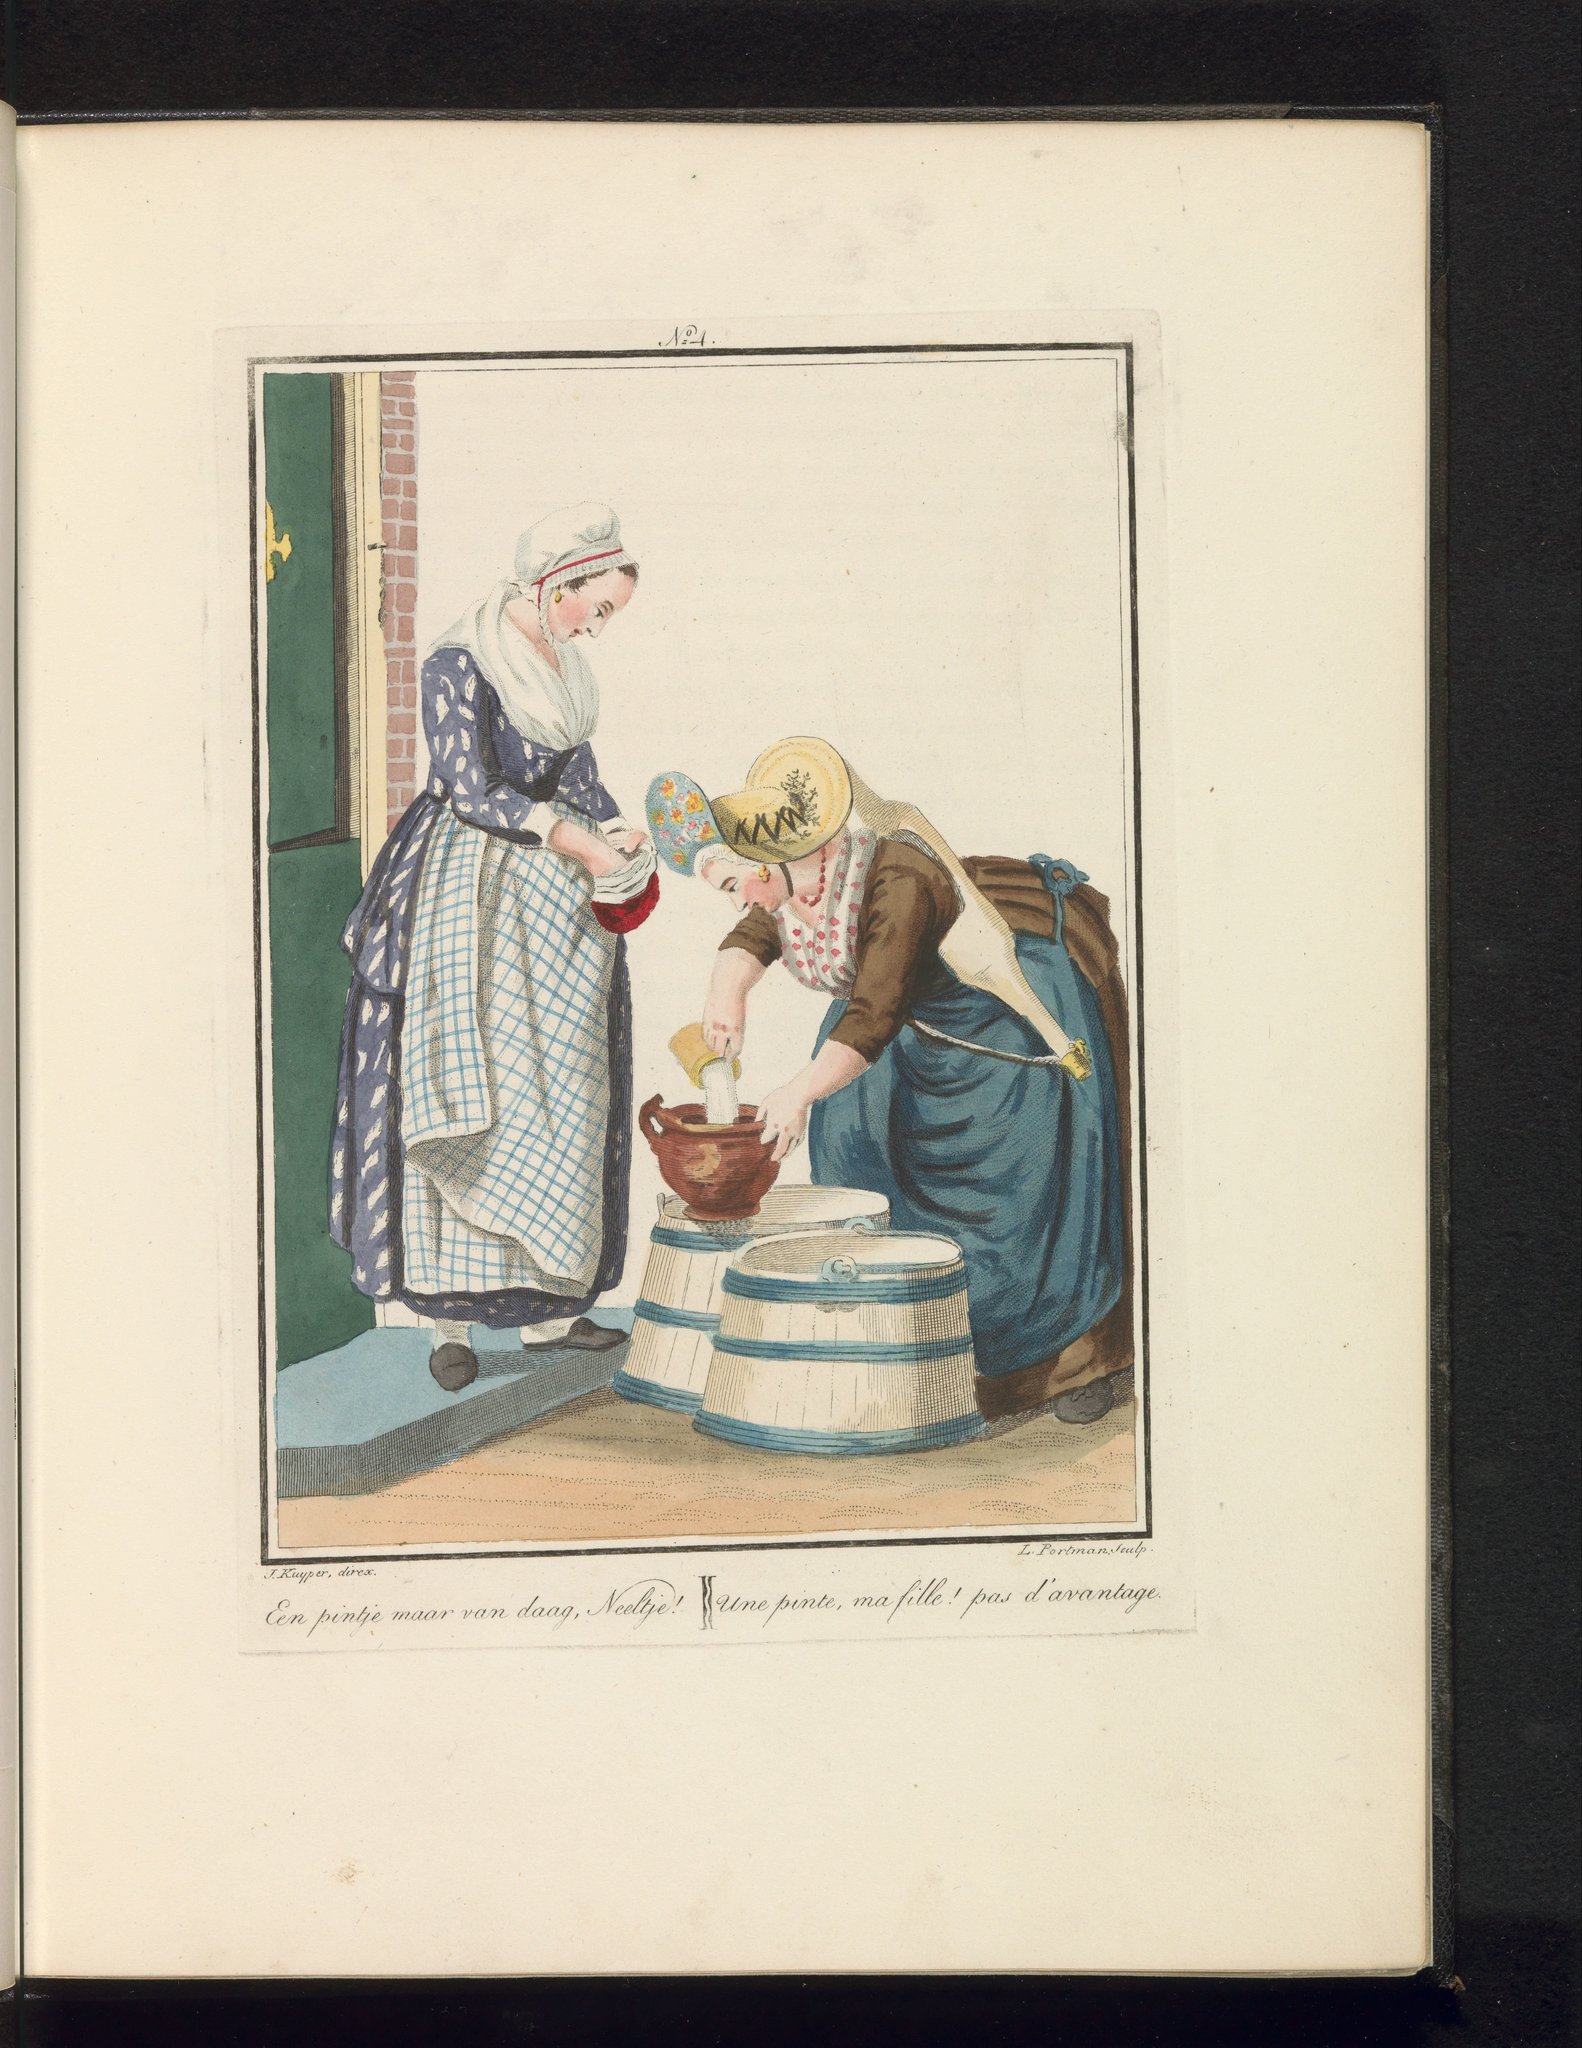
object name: book illustration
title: Een pintje maar van daag, Neeltje! / Une pinte, ma fille! pas d'avantage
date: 1803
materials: paper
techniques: etching, hand coloring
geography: netherlands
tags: street-trader - bb - women engaged in trade and commerce, milkmaid, clothes, costume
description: Gebruikt als illustratie in: Evert Maaskamp, Afbeeldingen van de kleedingen, zeden en gewoonten in de noordelijke provincien van het Koningrijk der Nederlanden, met den aanvang der negentiende eeuw = Tableaux des habillemens, mœurs et coutumes dans les provinces septentrionales du Royaume des Pays-Bas, au commencement du dix-neuvième siècle. Amsterdam: Evert Maaskamp, 1829 [heruitgave van de oorspronkelijke platen eerst verschenen in 1803-1807].